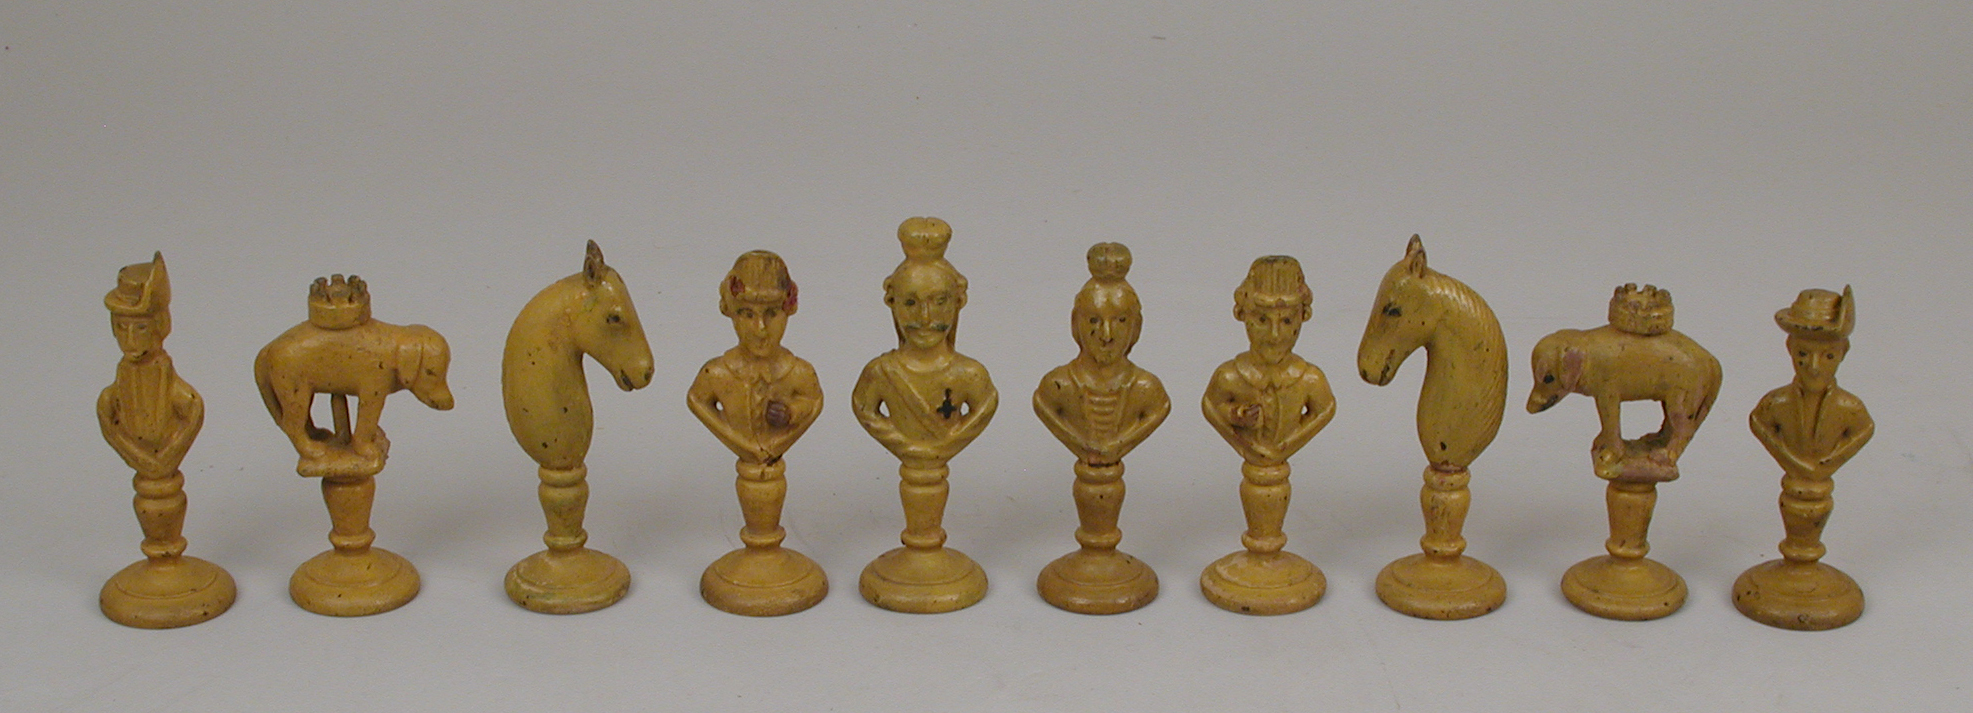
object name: chessman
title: Chessmen (32)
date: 1801-1900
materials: wood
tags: chess